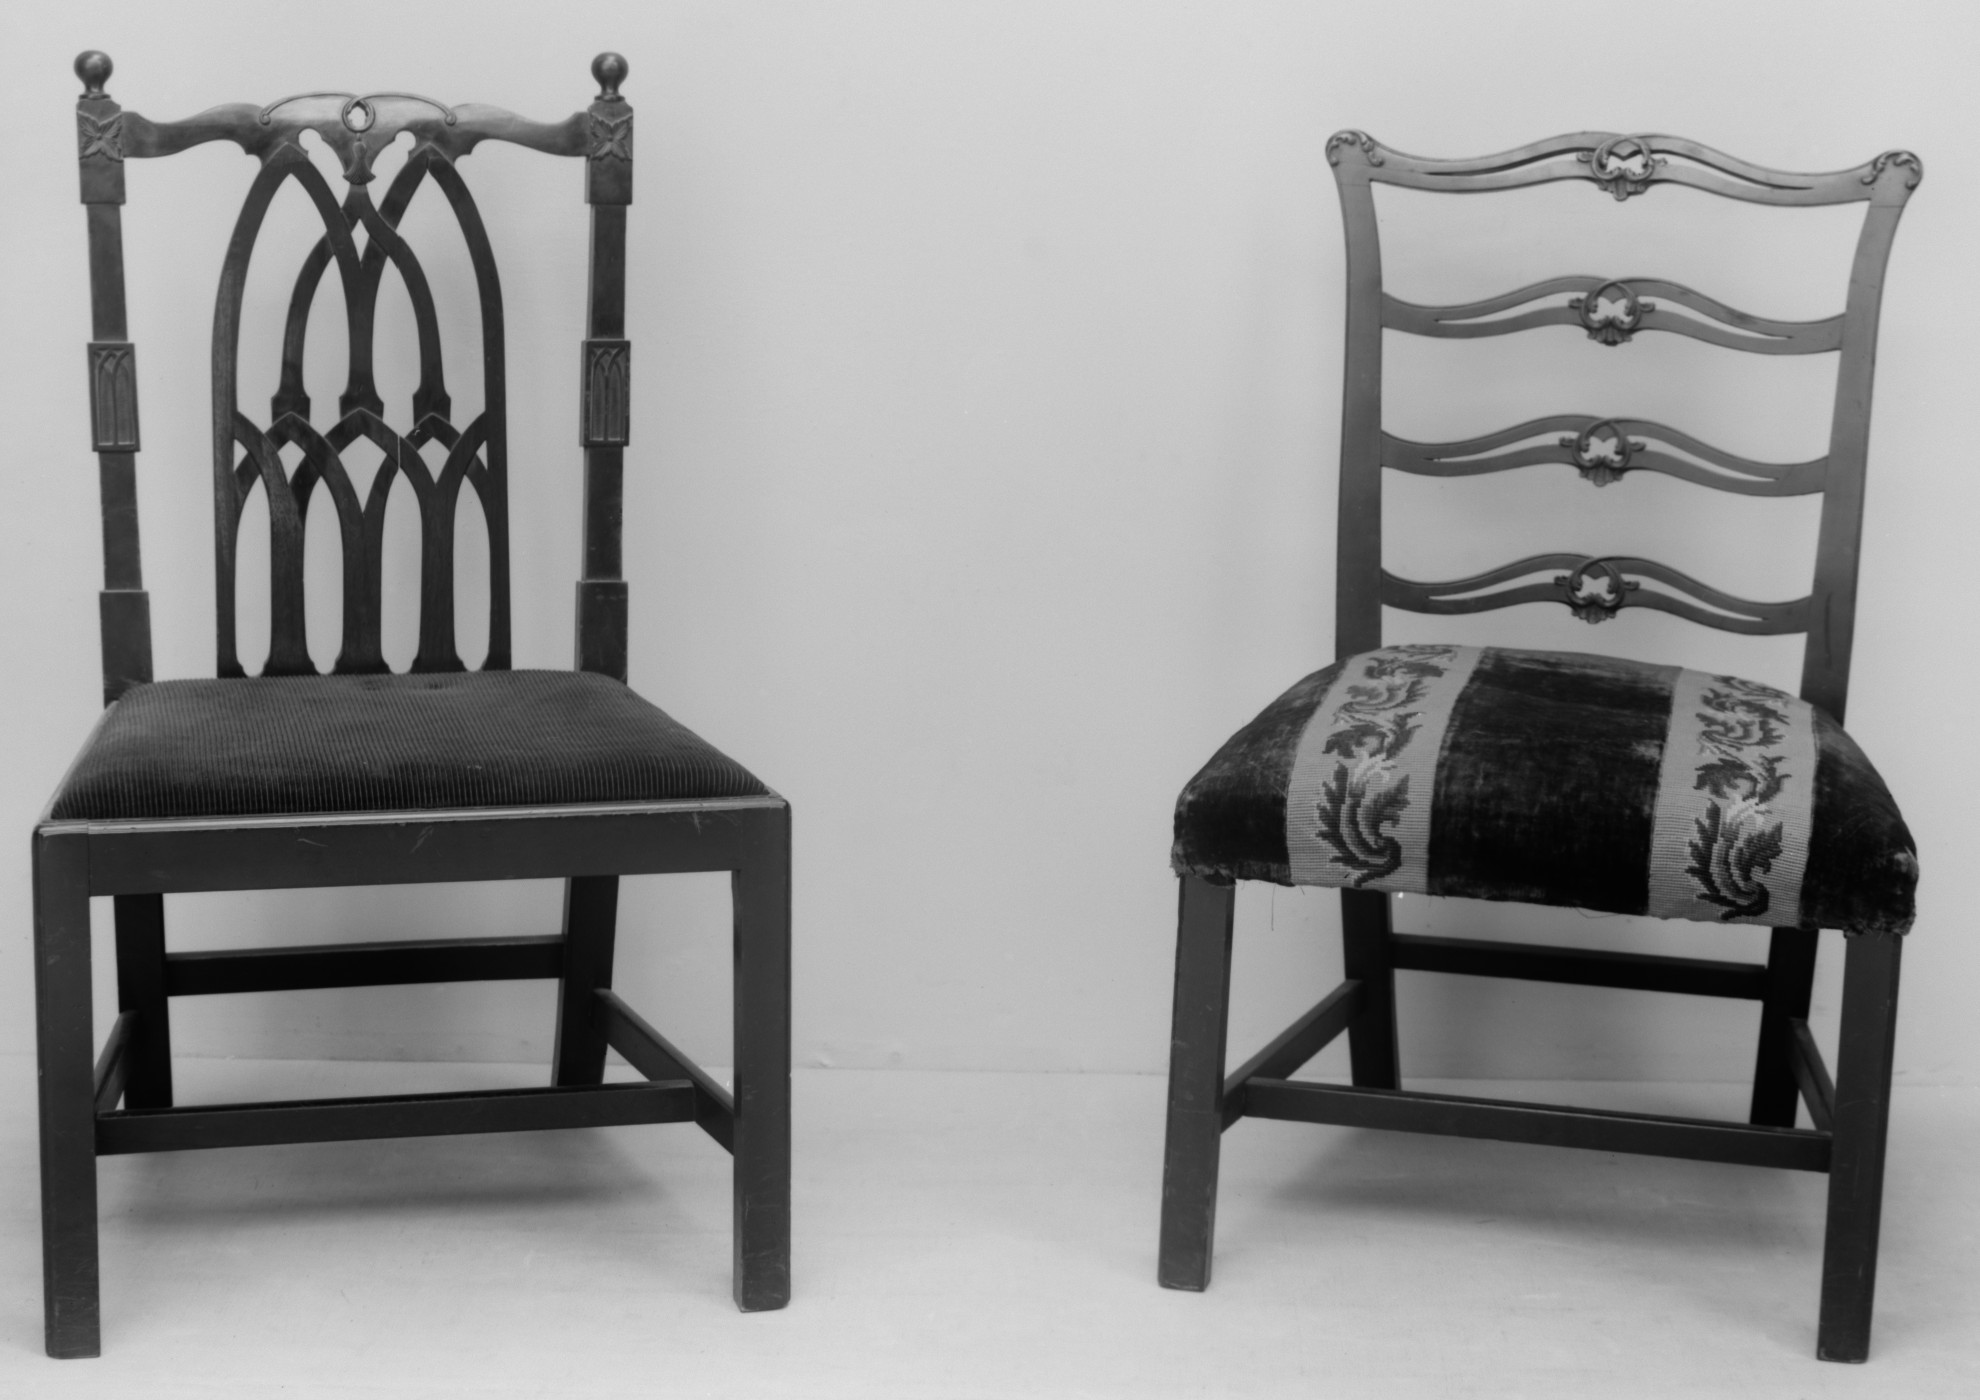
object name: ladder back chair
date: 1760-1770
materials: wood